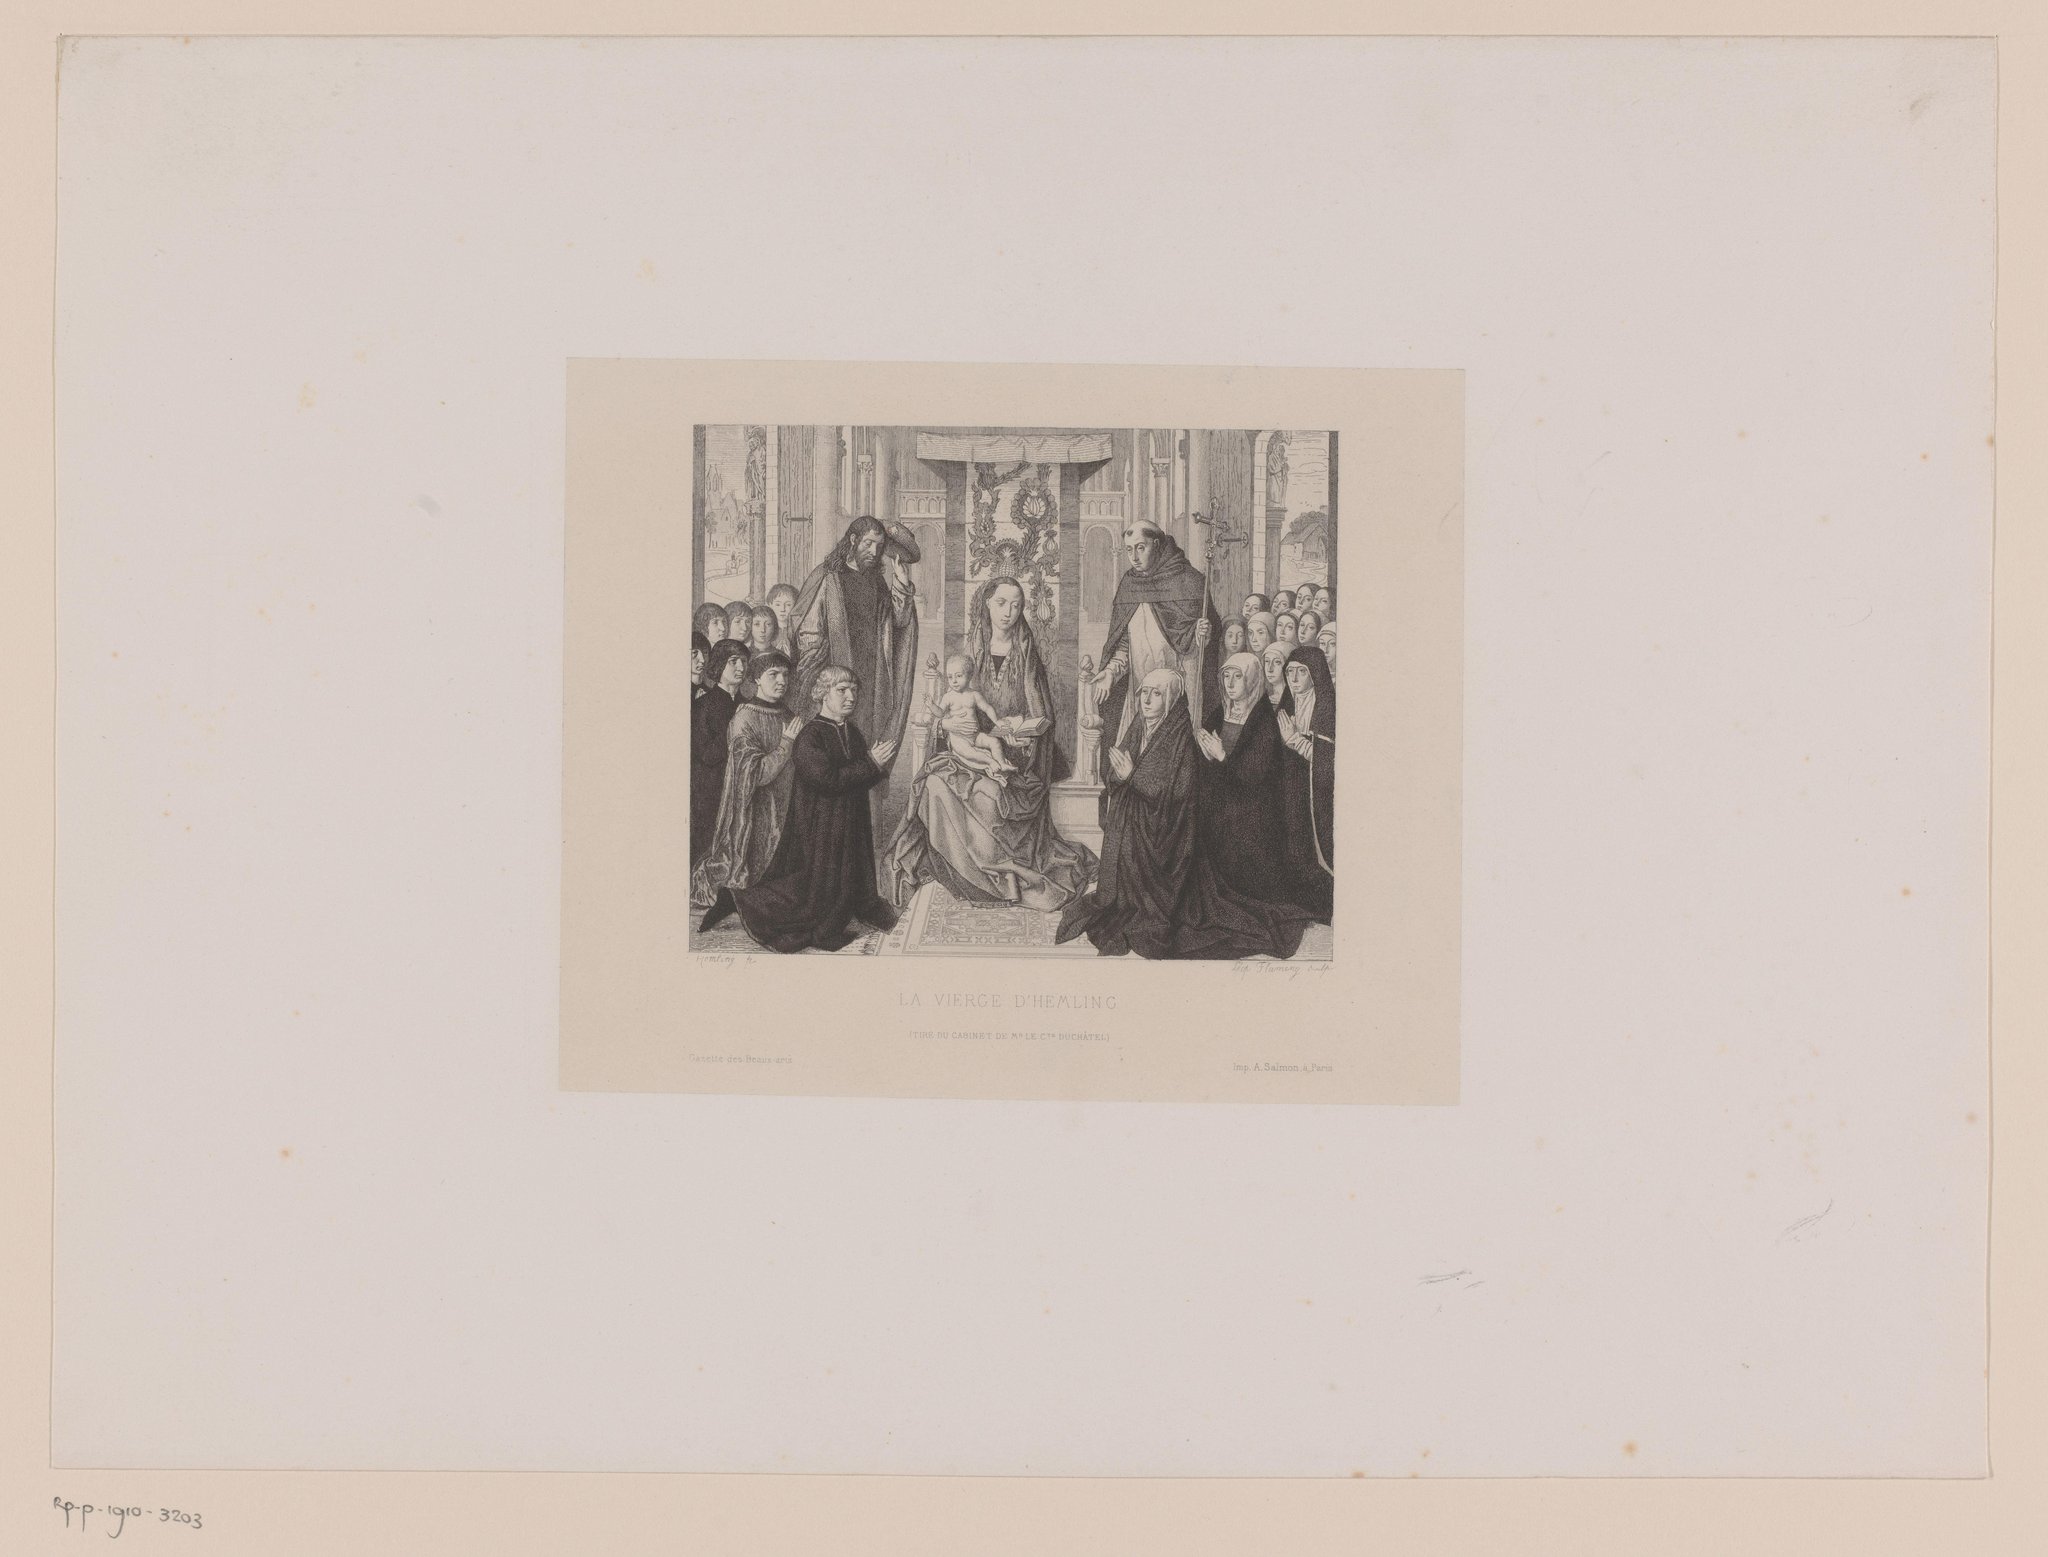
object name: print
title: Aanbidding van Maria met Christus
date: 1862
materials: paper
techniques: etching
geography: paris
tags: mary sitting or enthroned, the christ-child sitting on her knee (christ-child to mary's left)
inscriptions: collector's mark: Lugt 2228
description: Prent uit: Gazette des beaux-arts (1862), dl. 1, p. 249.